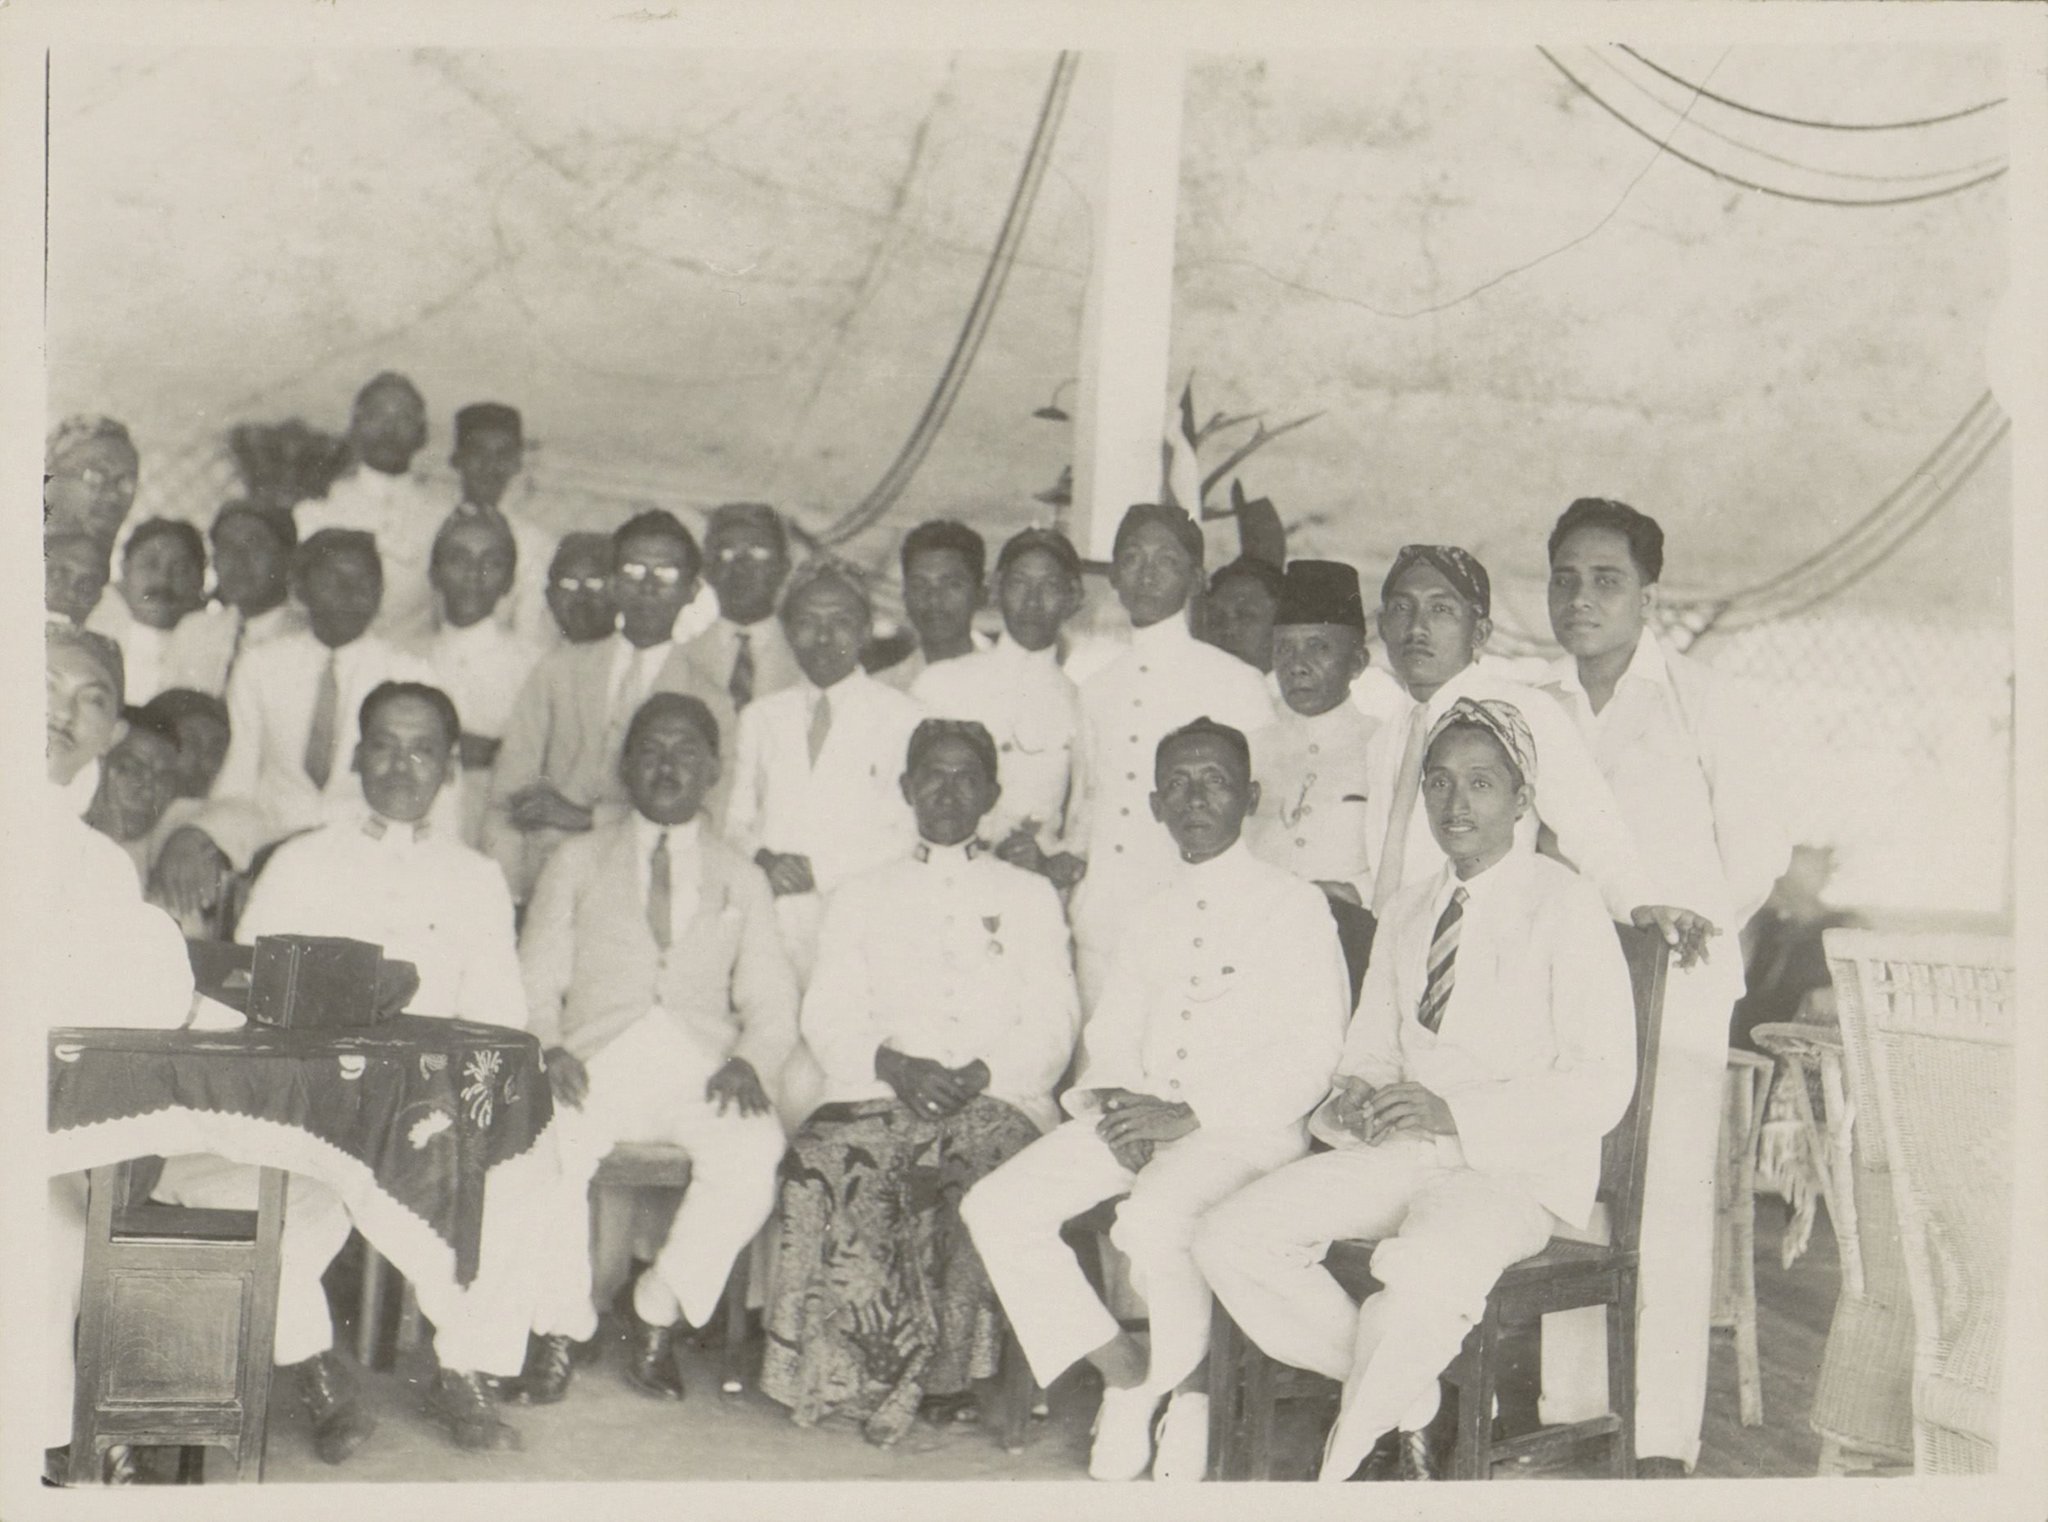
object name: photograph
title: Mannen bij elkaar in een pendoppo in Gadingredjo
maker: Anonymous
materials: photographic support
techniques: gelatin silver print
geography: gadingredjo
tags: meeting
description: Onderdeel van Fotoalbum aangeboden aan de resident der Lampongse districten F.J. Junius door studerende ambtenaren van de bestuursschool te Batavia.